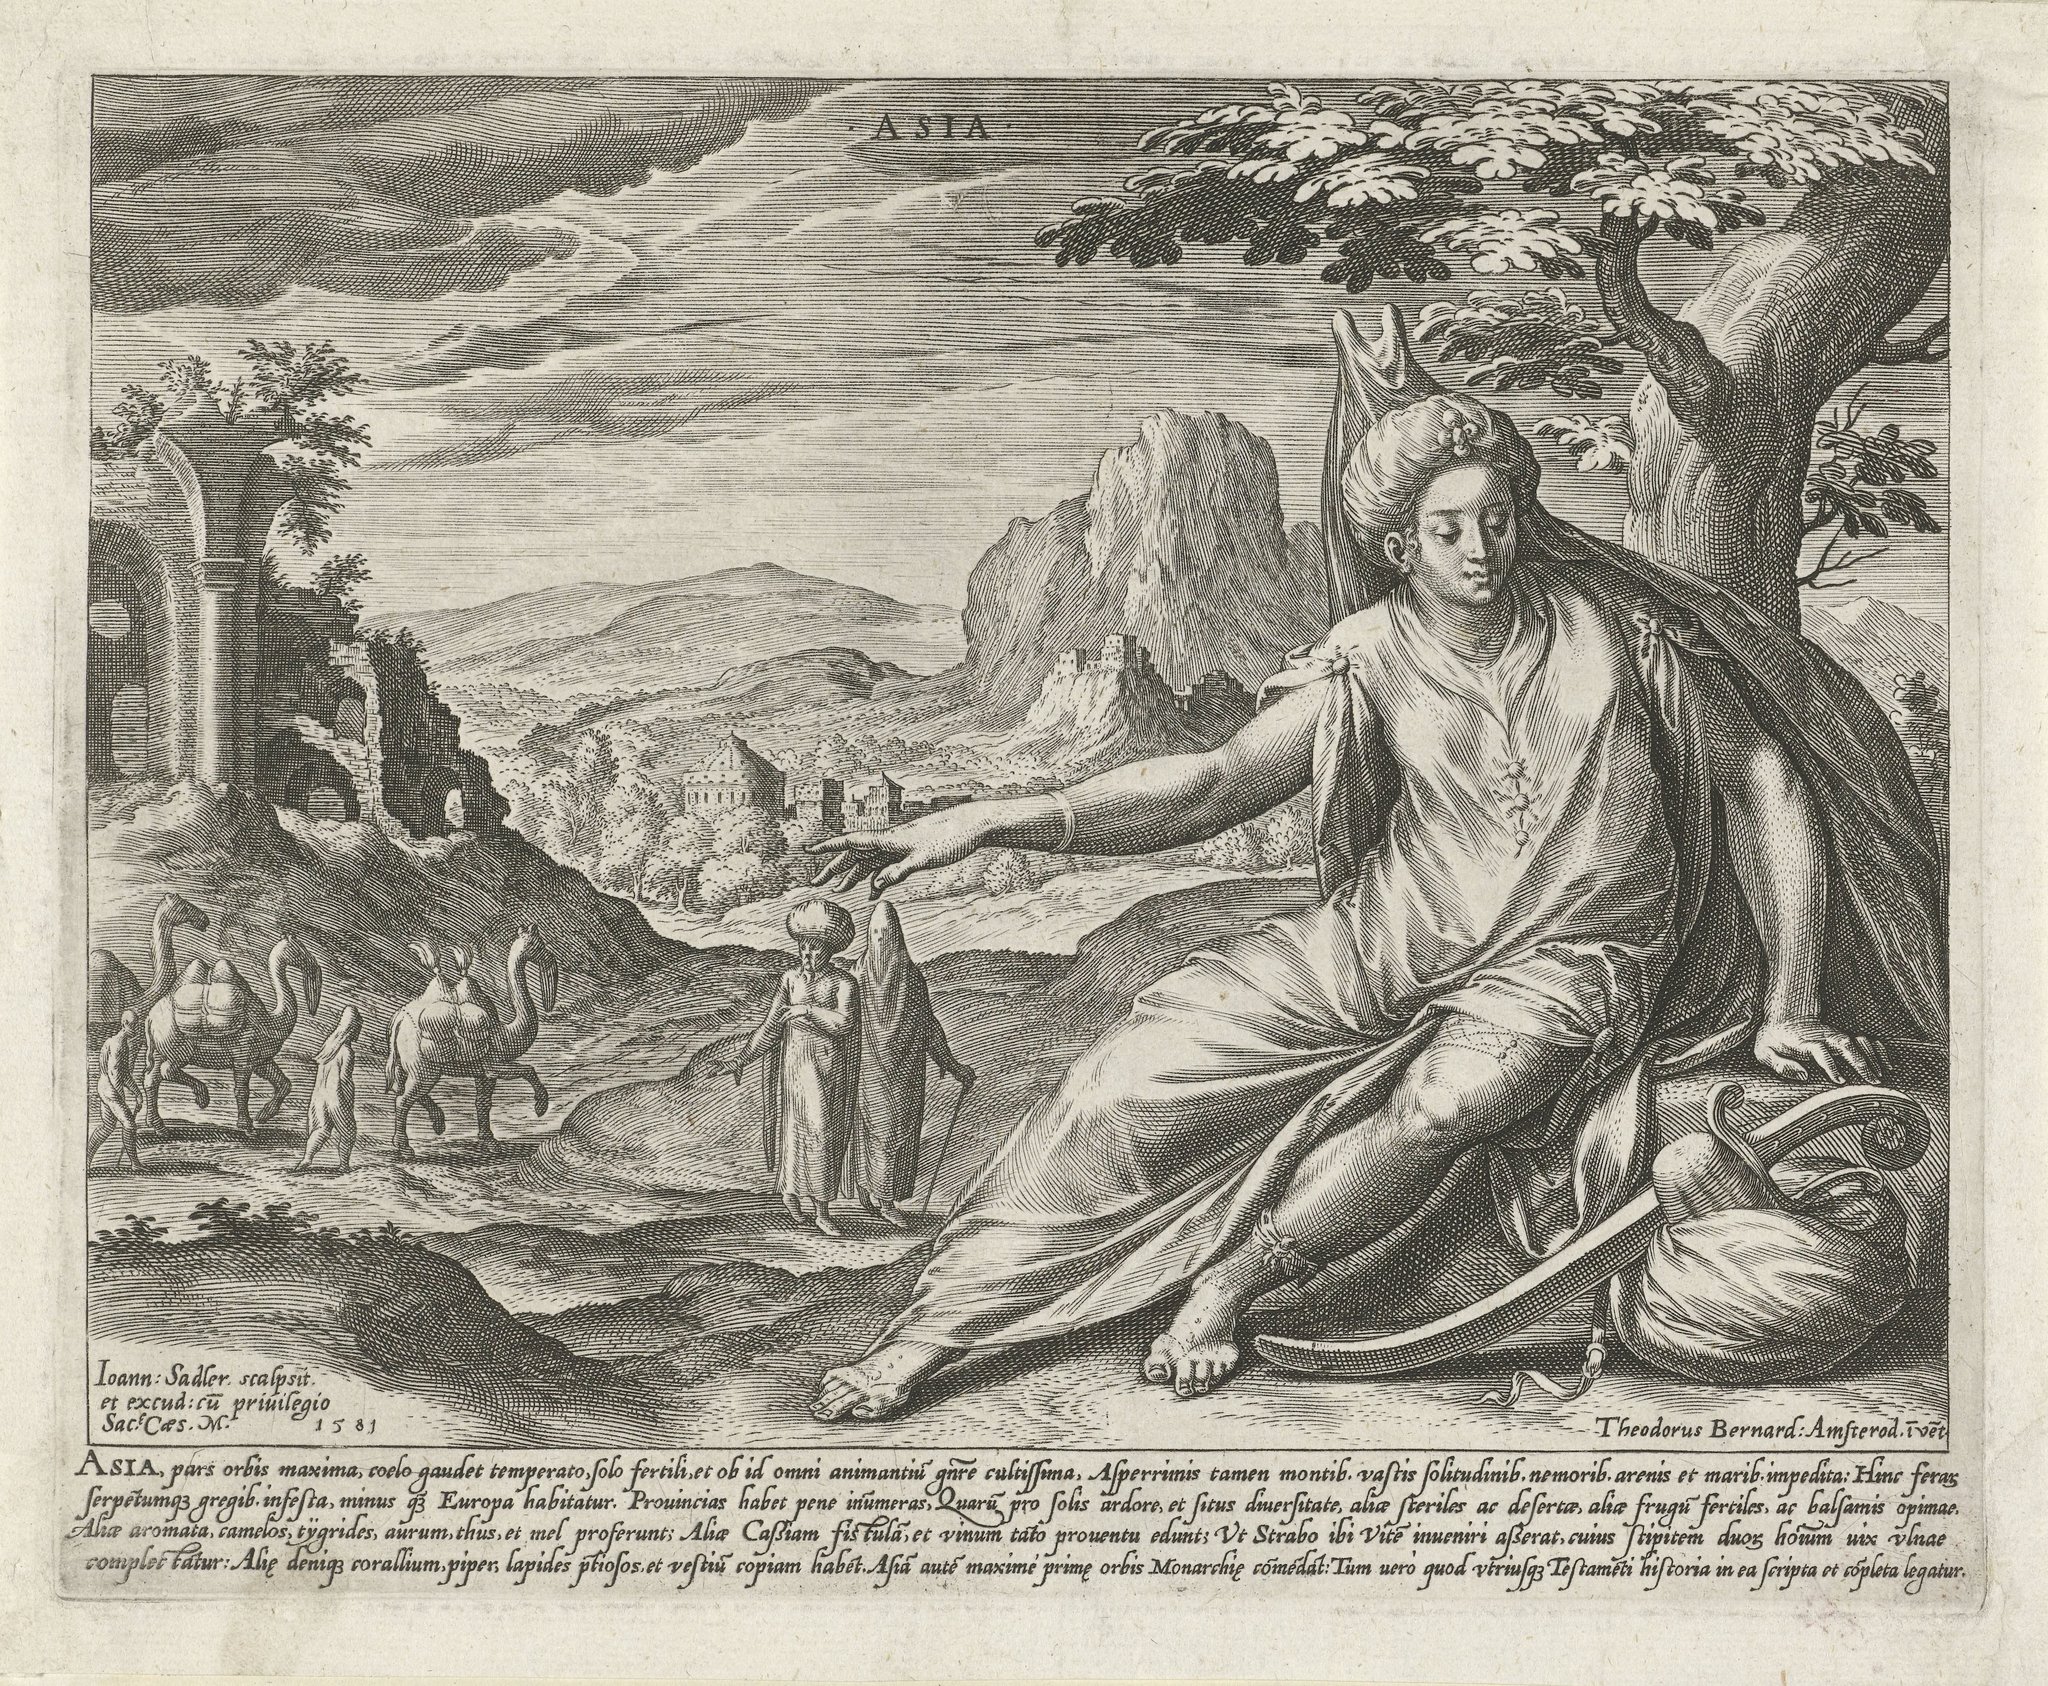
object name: print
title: Asia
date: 1581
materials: paper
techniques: engraving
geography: cologne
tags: hoofed animals: camel, asiatic races and peoples, landscapes, asia represented allegorically; 'asia' (ripa), hacking and thrusting weapons, head-gear: turban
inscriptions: collector's mark: Lugt 240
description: De vrouwelijke personificatie van het continent Azië op de voorgrond. Naast haar liggen een zwaard en een tulband. Op de achtergrond een Oosters landschap met een Oosters gekleed paar en enkele kamelen. De prent heeft een Latijns onderschrift en is deel van een vierdelige serie met personificaties van de vier continenten.